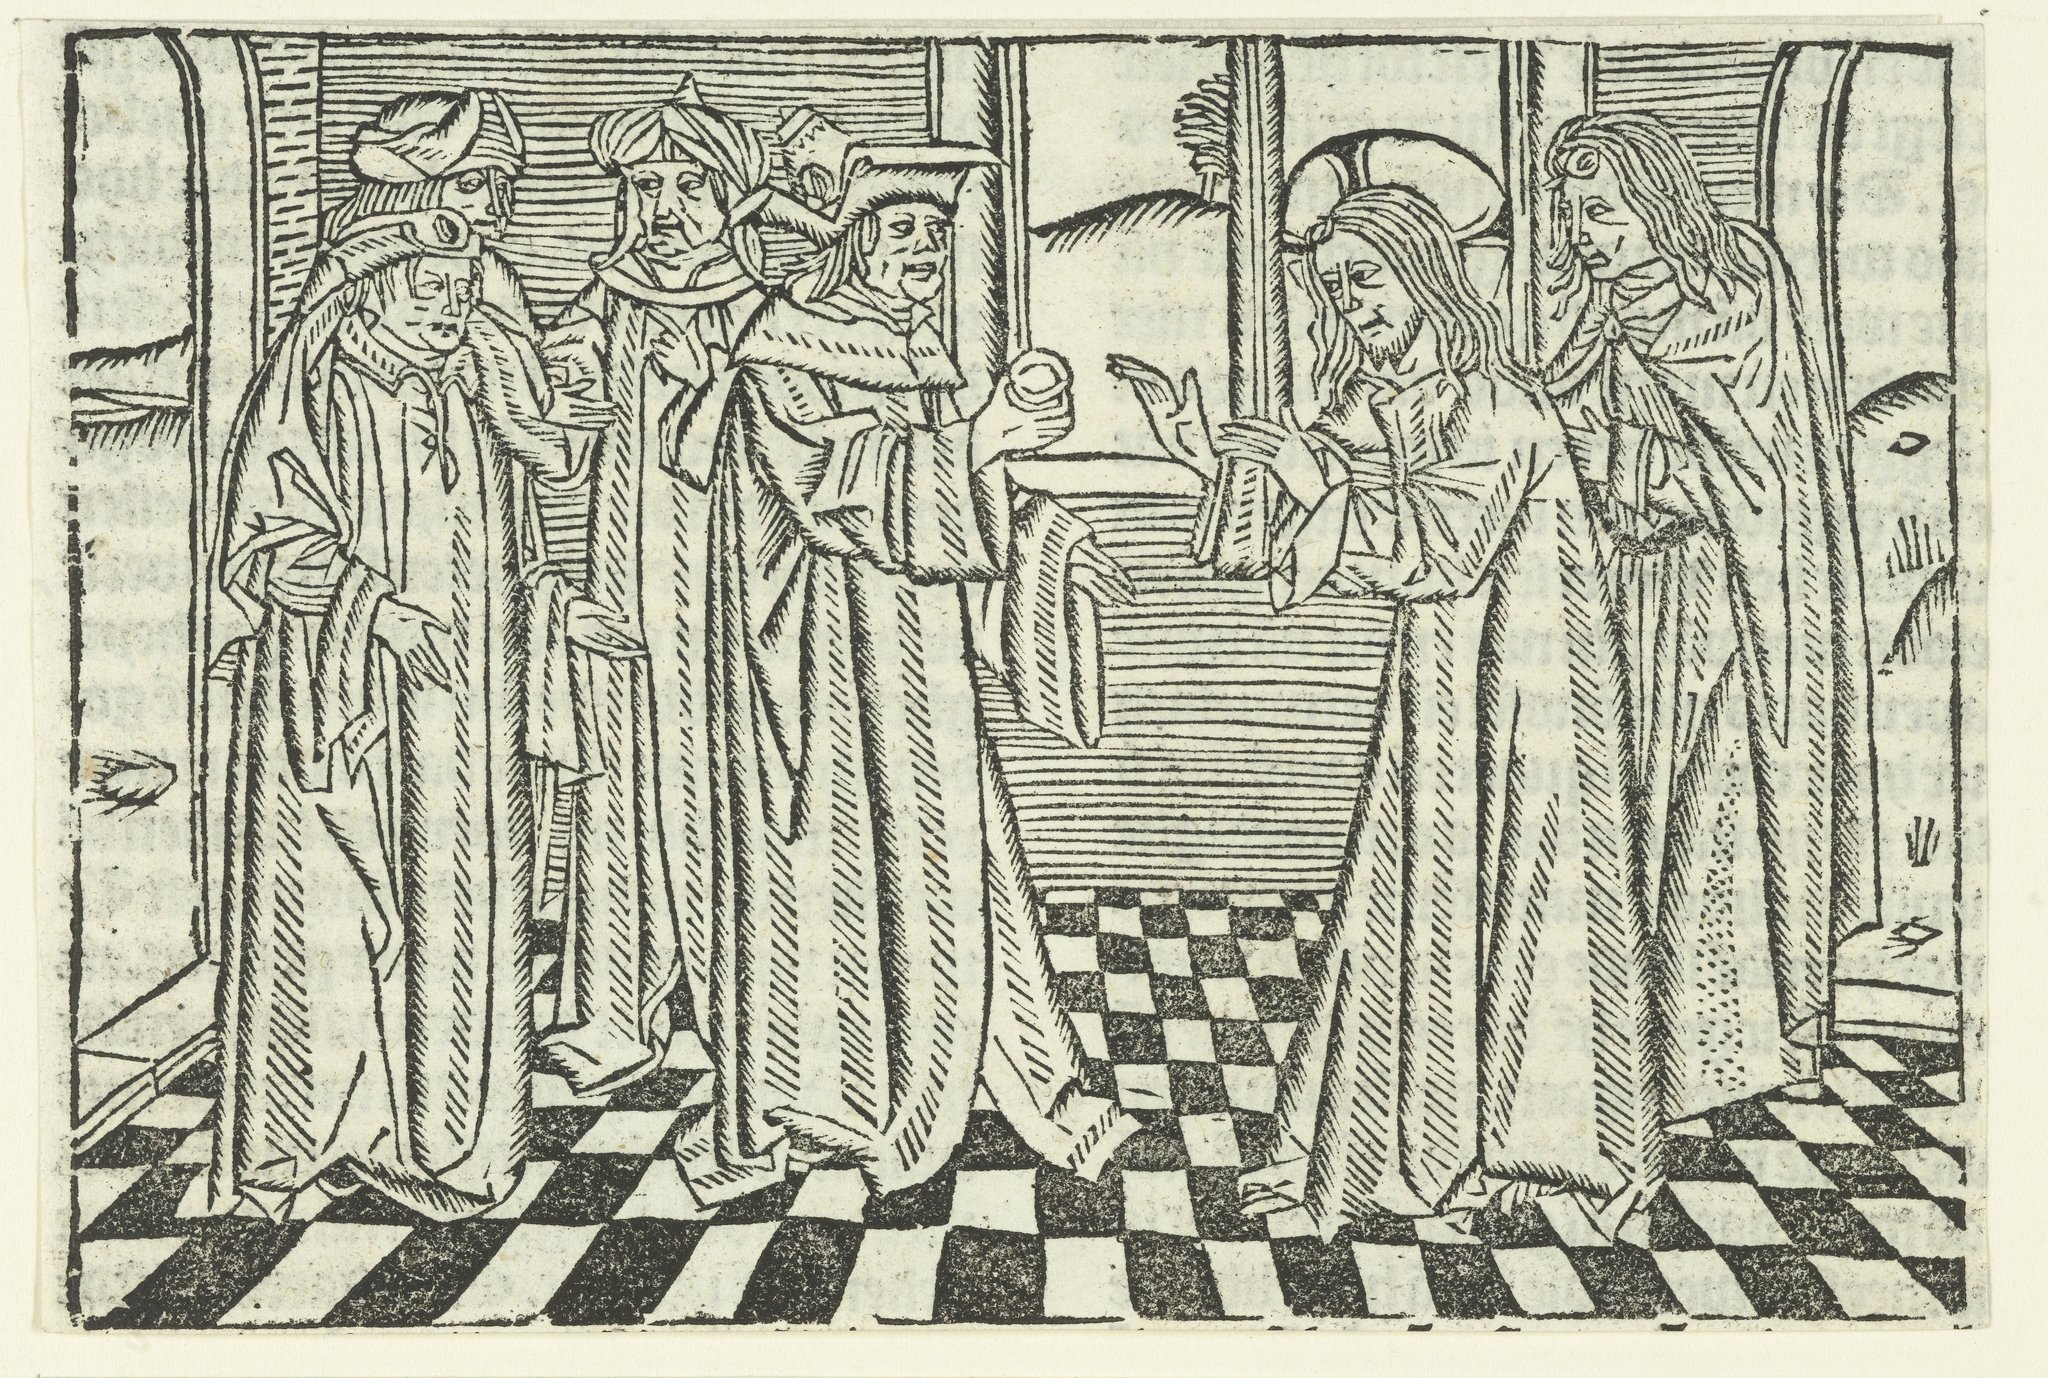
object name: book illustration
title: Strikvraag van de Farizeeërs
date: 1480-1500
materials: paper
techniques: woodcut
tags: christ (in the temple) in debate with pharisees about the tribute to caesar (matthew 22:15-22; mark 12:13-17; luke 20:20-26)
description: Eén blad van 113 uit Ludolphus de Saxonia, "Dit es dleué ons liefs heeren ihesu christi". Anonieme Nederlandse vertaling. Uitgegeven door Henrick Eckert van Homberch te Antwerpen in 1503. Botke, K. Deze 113 houtsneden, die meestal reeds in vroege Nederlandse boeken gebruikt zijn, worden toegeschreven aan de tweede Meester van Delft, de Meester van de Delbecq-Schreiber-passie en de Meester van de Virgo inter Virgines. In Conway (1884) en in "De gulden passer"(1951) zijn ook eerdere versies opgenomen. Botke, K.